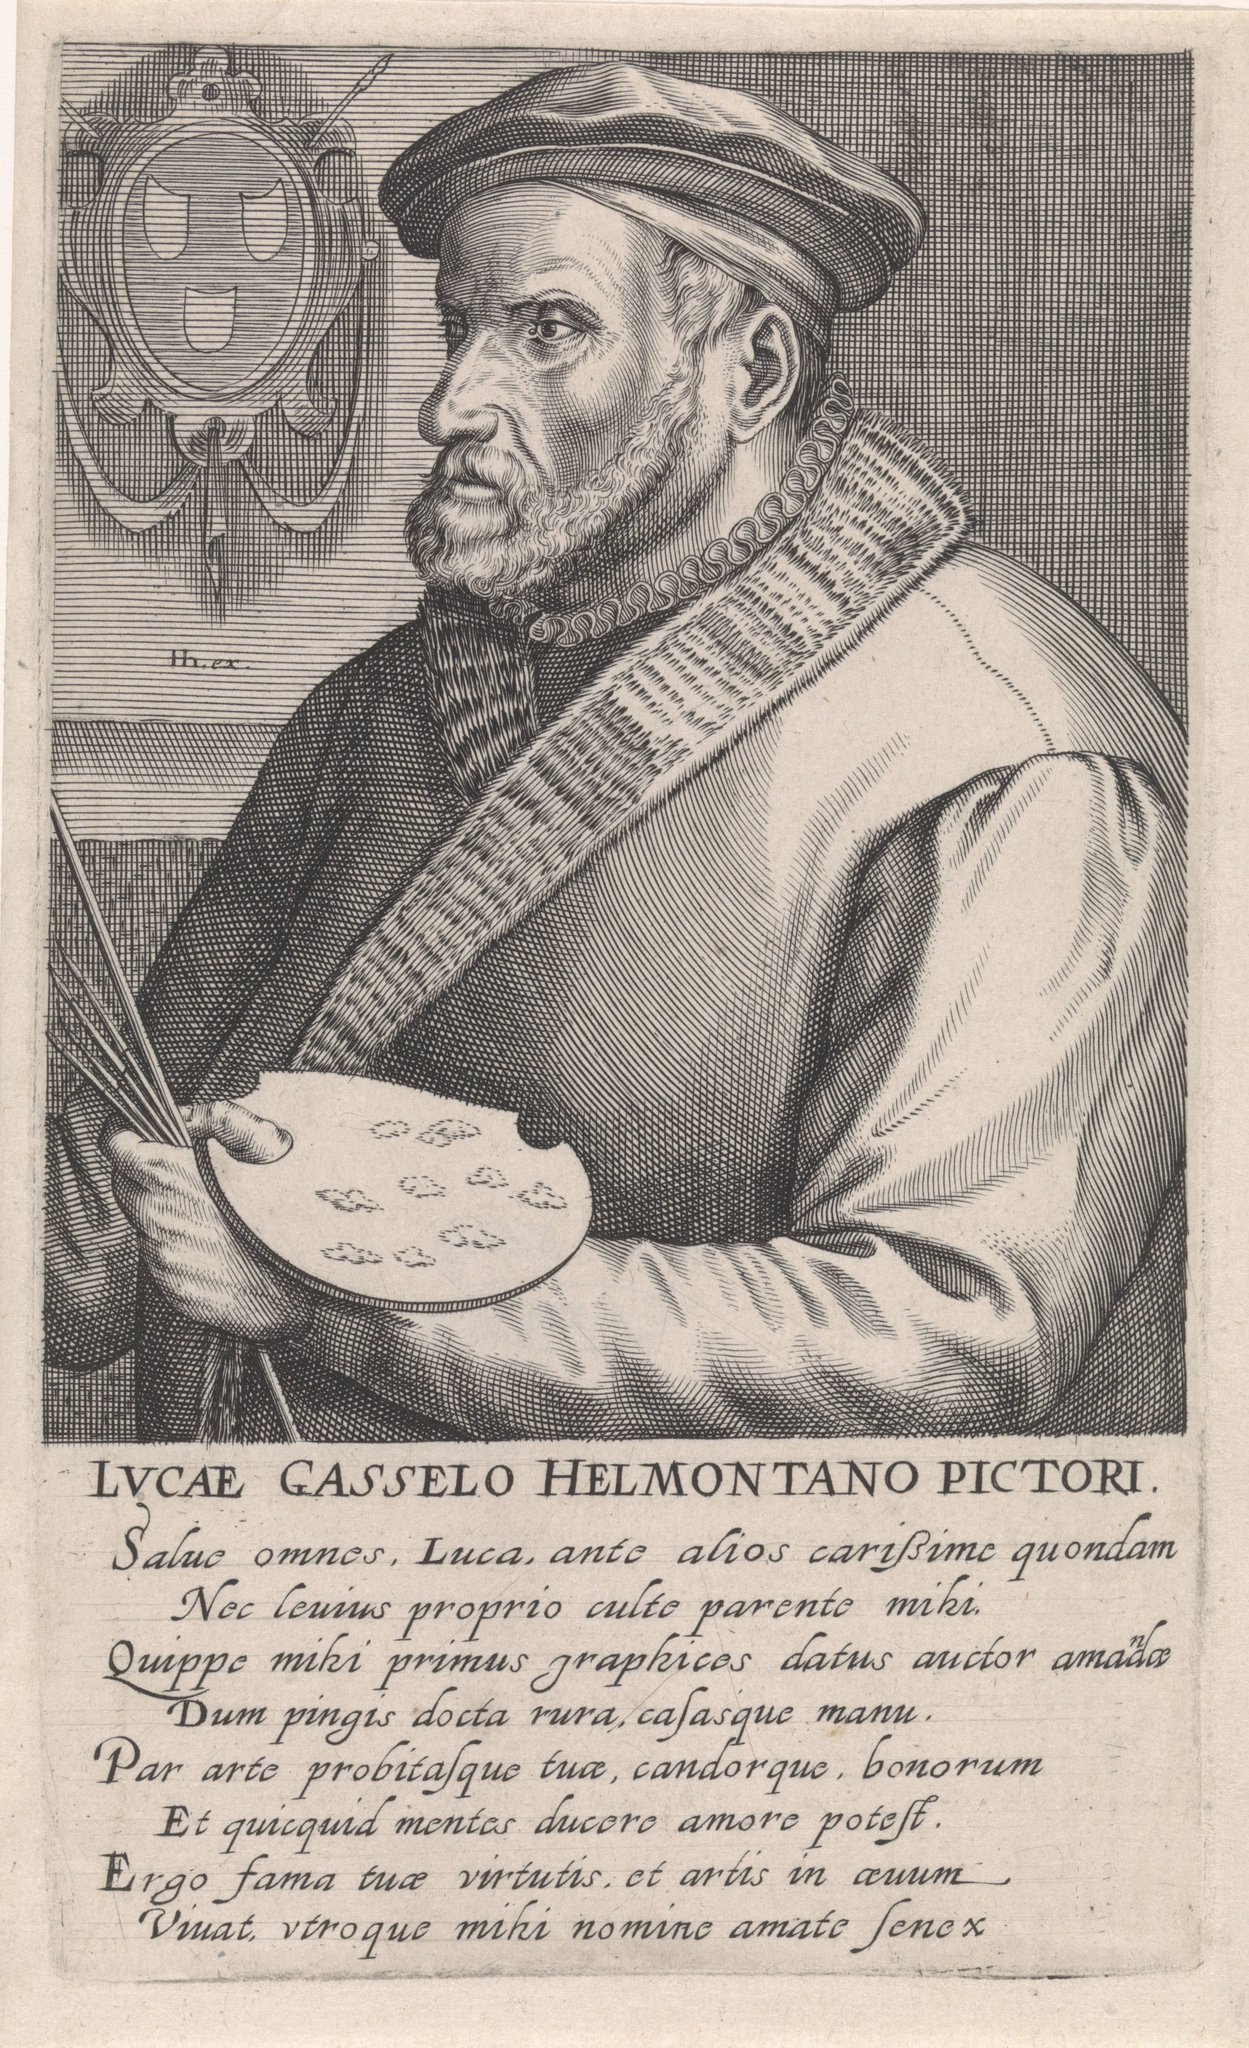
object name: print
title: Portret van Lucas Gassel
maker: hendrick hondius (i)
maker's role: draughtsman, print maker, publisher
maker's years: 1573-1650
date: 1610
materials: paper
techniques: engraving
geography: the hague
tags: lucas gassel, portrait, self-portrait of painter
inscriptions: collector's mark: Lugt 2228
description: Portret ten halven lijve naar links van Lucas Gassel. Onder het portret zijn naam en acht regels in het Latijn. Prent uit deel 1 van de serie Pictorum Aliquot Celebrium Praecipuae Germaniae Inferioris Effigies. Serie van 72 kunstenaarsportretten vervaardigd door Hendrick Hondius I, Simon Frisius, Andries Jacobsz. Stock en Robert de Baudous.